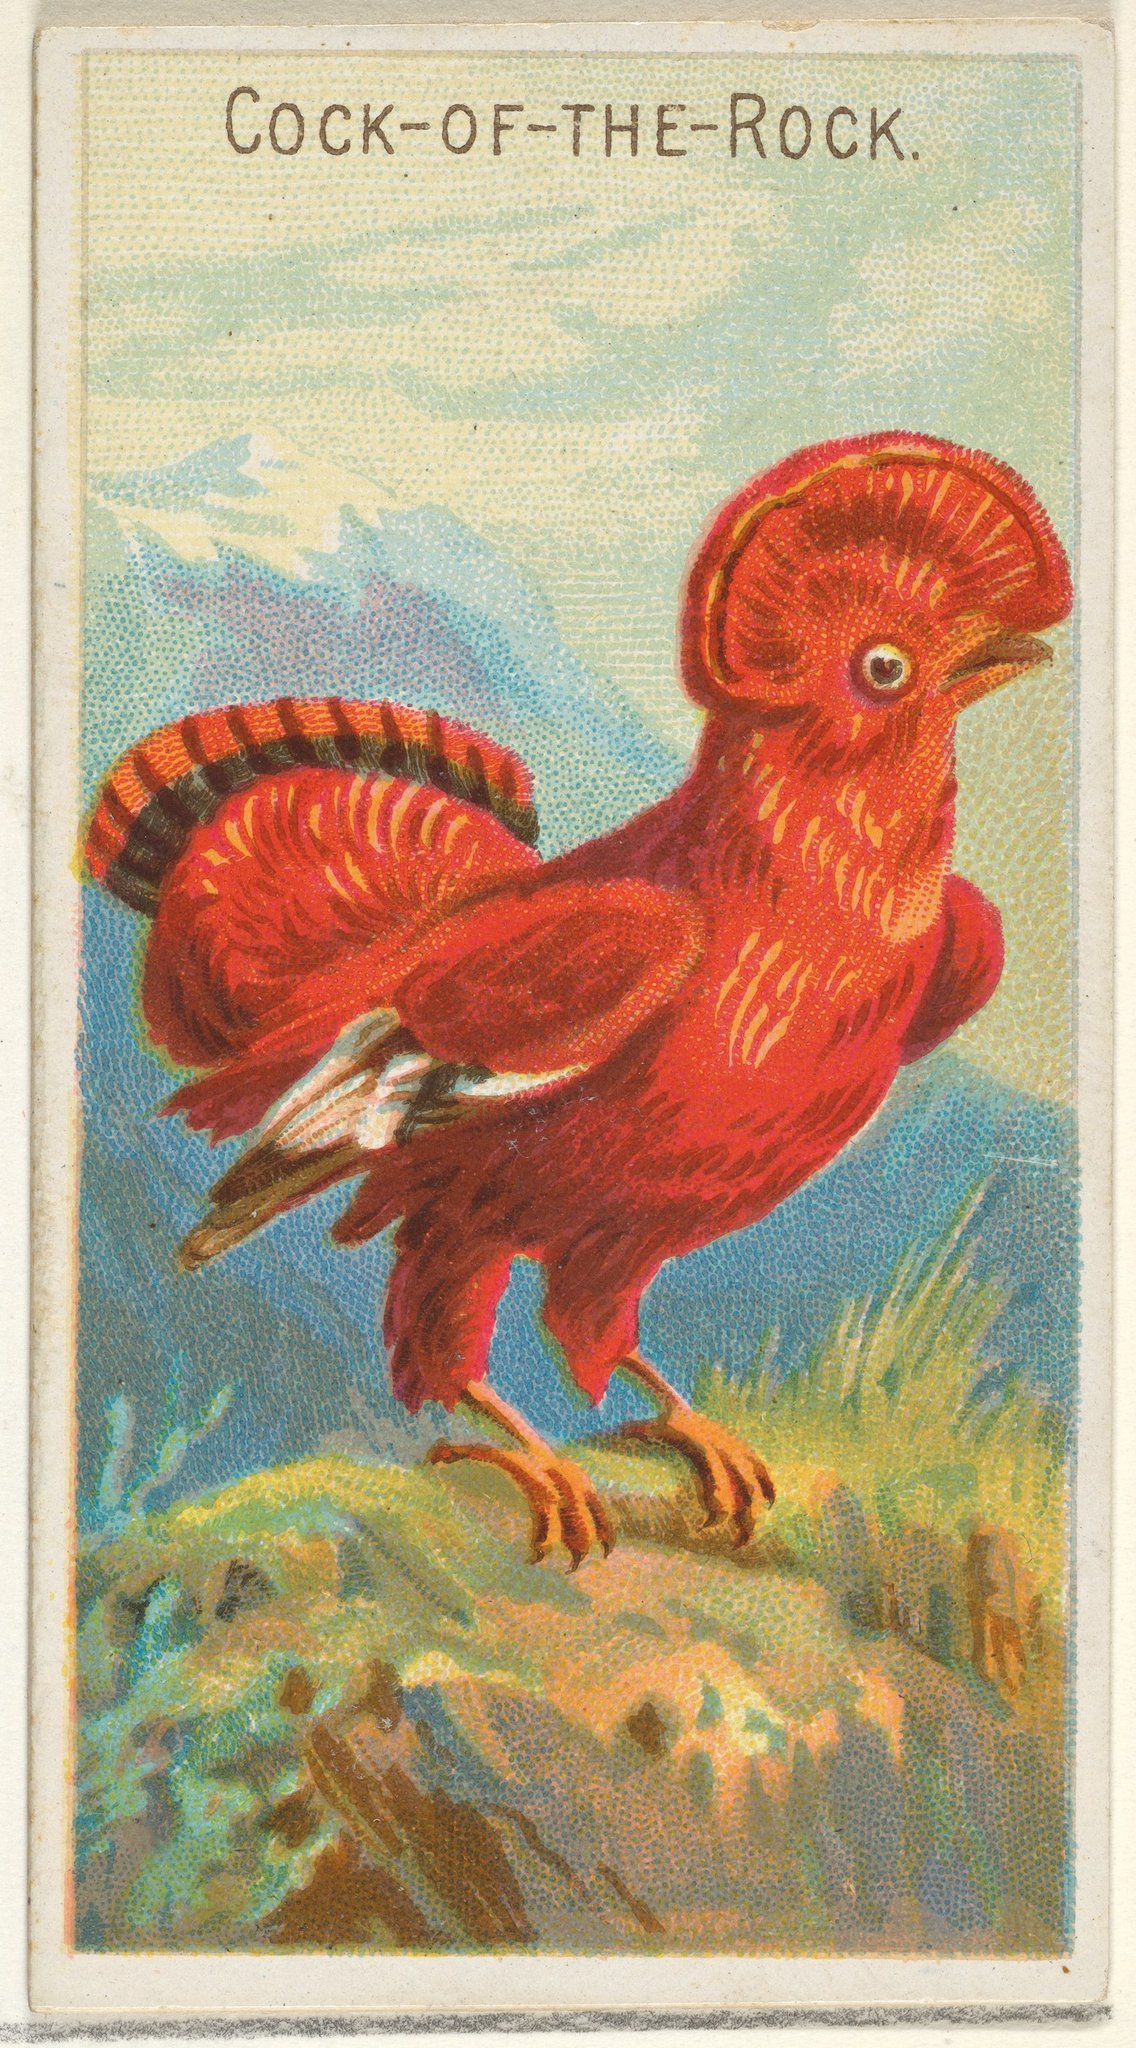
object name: print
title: Cock-of-the-Rock, from the Birds of the Tropics series (N5) for Allen & Ginter Cigarettes Brands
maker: allen & ginter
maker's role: publisher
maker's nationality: american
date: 1889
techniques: color lithograph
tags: roosters